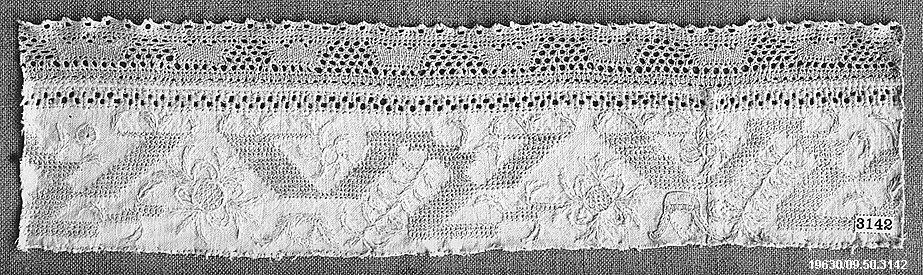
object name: fragment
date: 1701-1733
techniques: lace